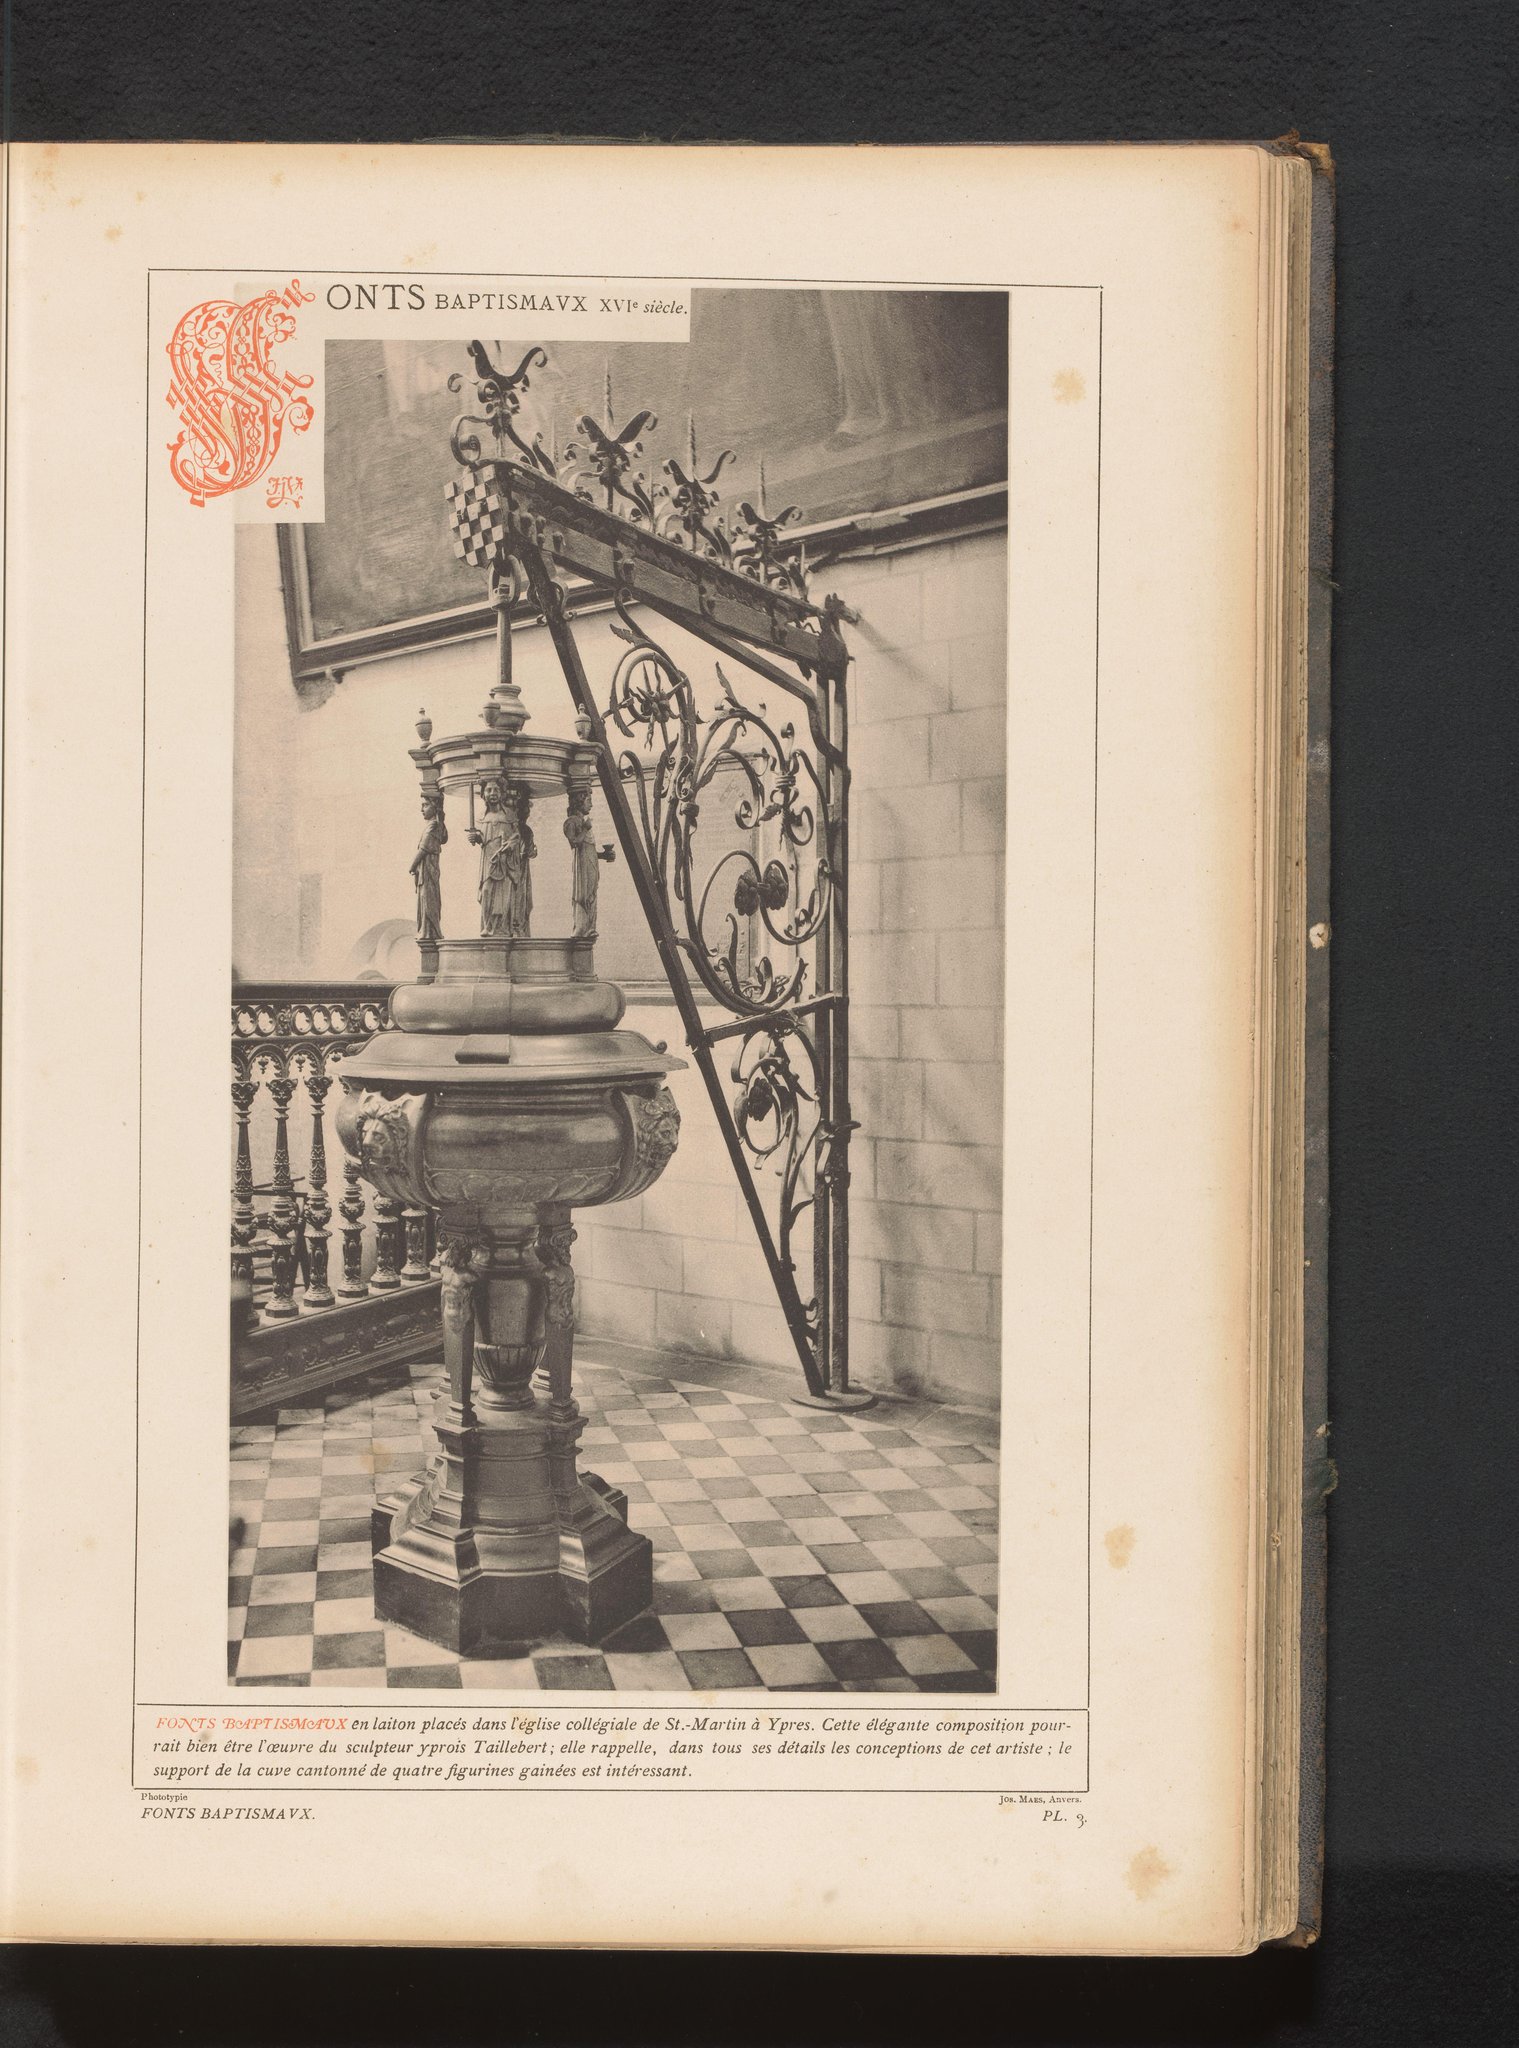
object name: photomechanical print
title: Messing doopvont in de Sint-Maartenskerk in Ieper, België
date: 1882-1887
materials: paper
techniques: photograph, photolithography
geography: ieper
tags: baptismal font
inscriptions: monogram: ‘JJvY’, inscription: ‘FONTS BAPTISMAUX en (...)’, inscription: ‘FONTS BAPTISMAUX. - PL. 3.’